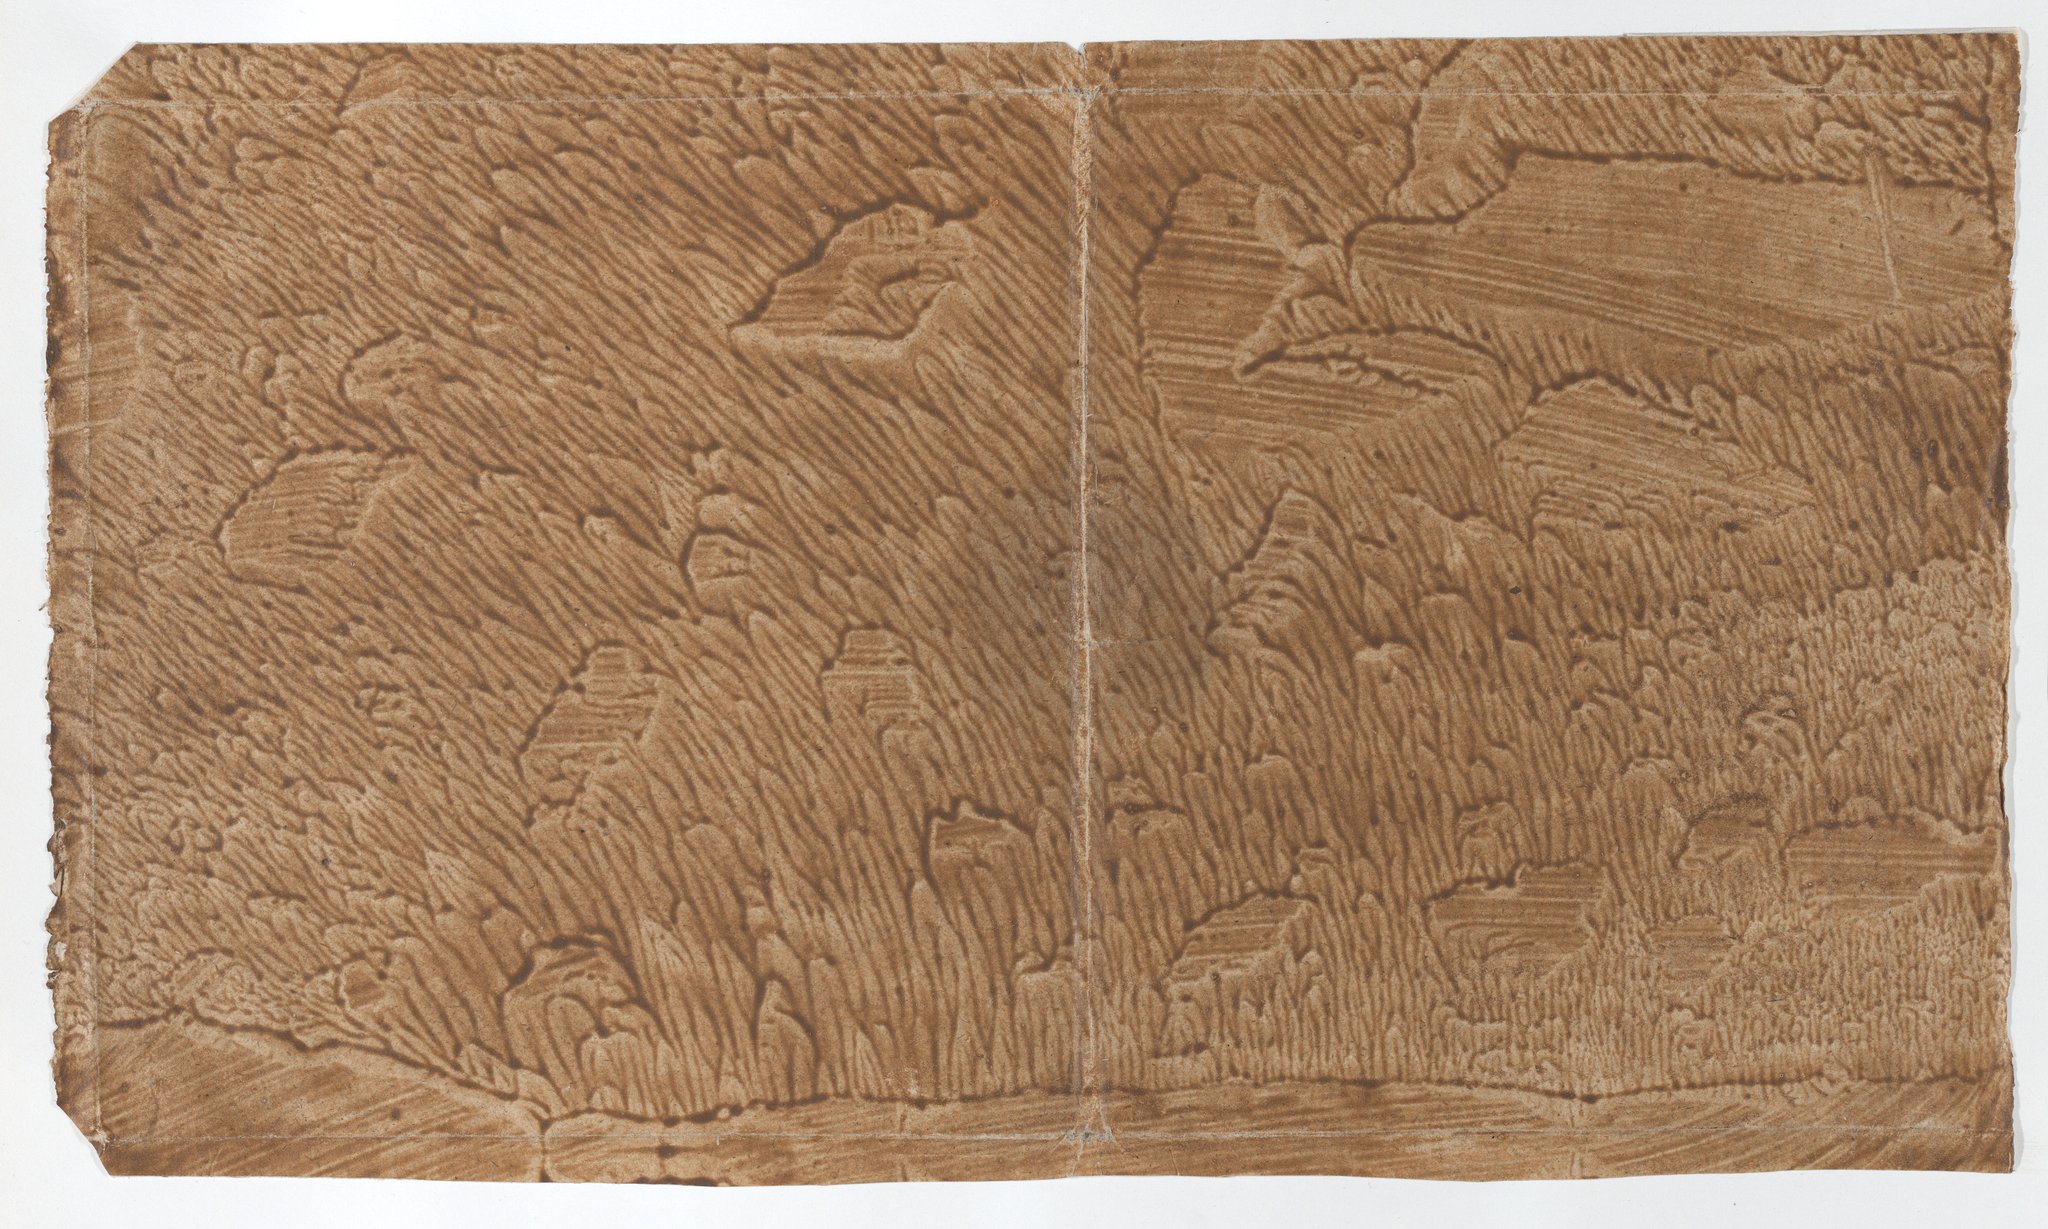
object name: print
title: Brown paste paper book cover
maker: Anonymous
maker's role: artist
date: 1801-1900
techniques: relief print